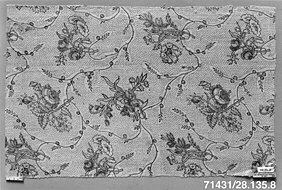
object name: floral print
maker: oberkampf manufactory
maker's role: manufactory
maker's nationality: french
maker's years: 1760-1843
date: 1770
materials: cotton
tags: flowers,leaves